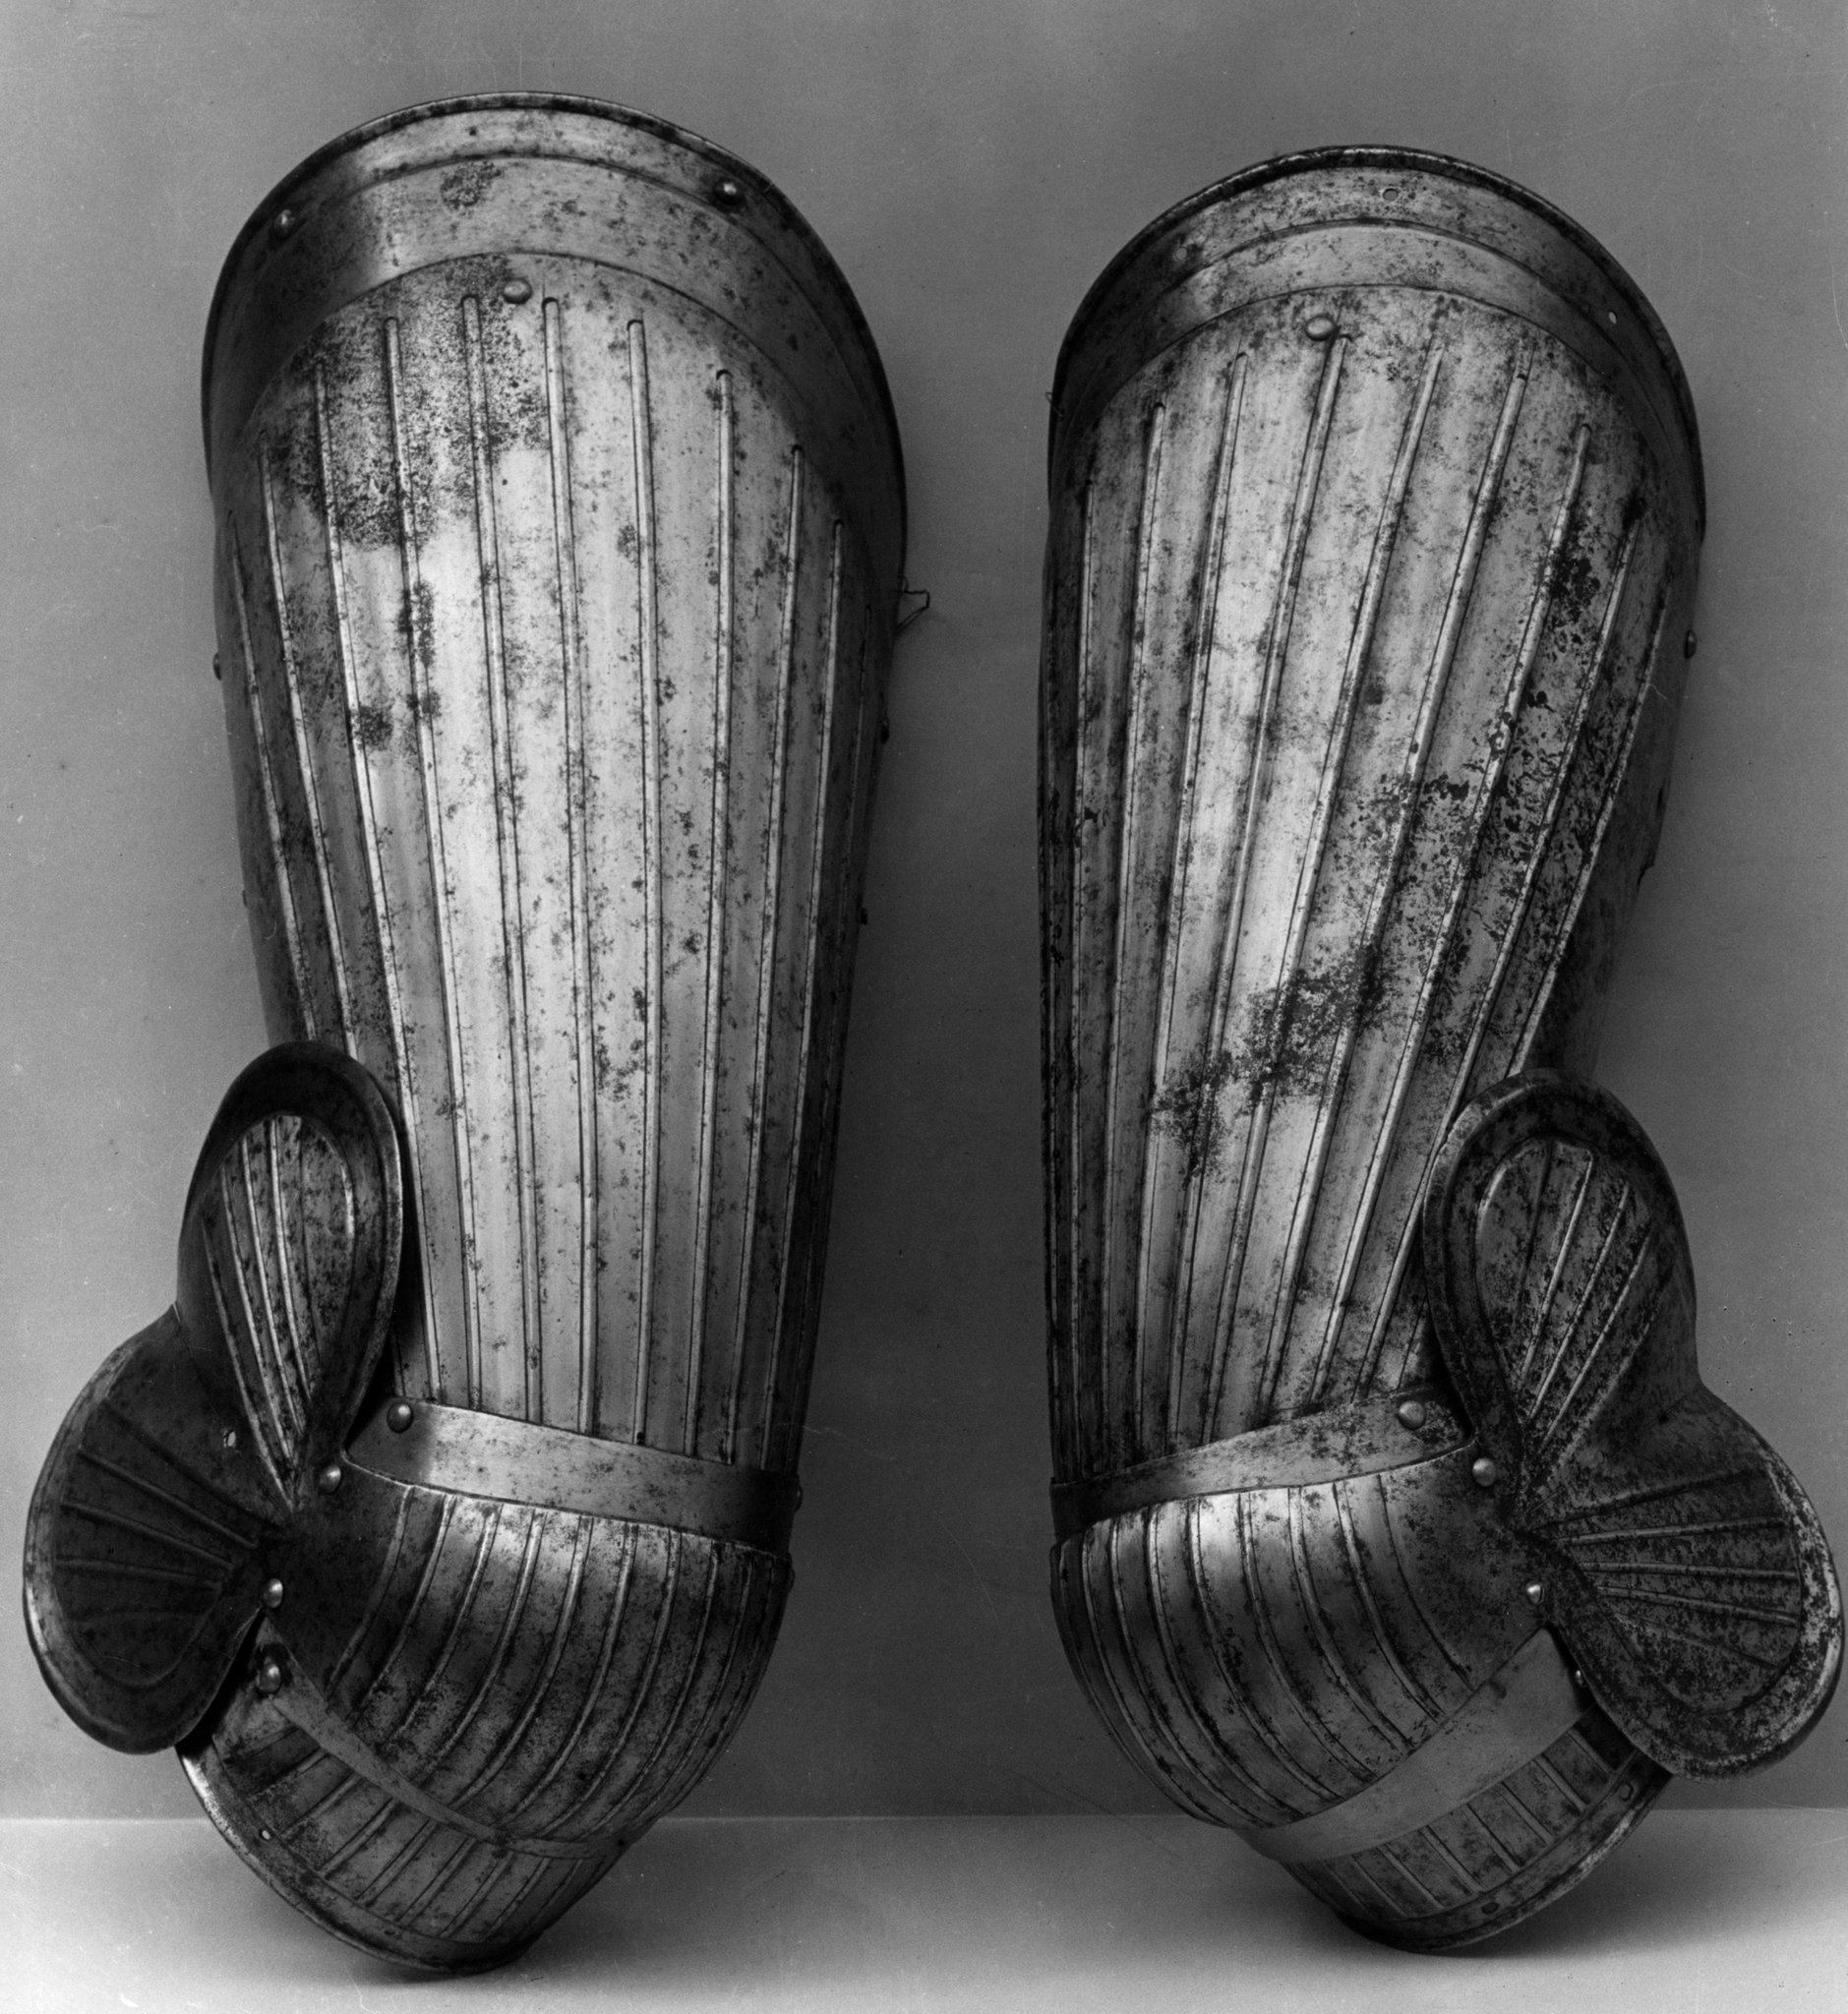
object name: pair of thigh defense cuisse with knee defense poleyns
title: Pair of Thigh Defenses (Cuisses) with knee defenses (Poleyns)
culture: german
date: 1501-1600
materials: steel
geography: germany